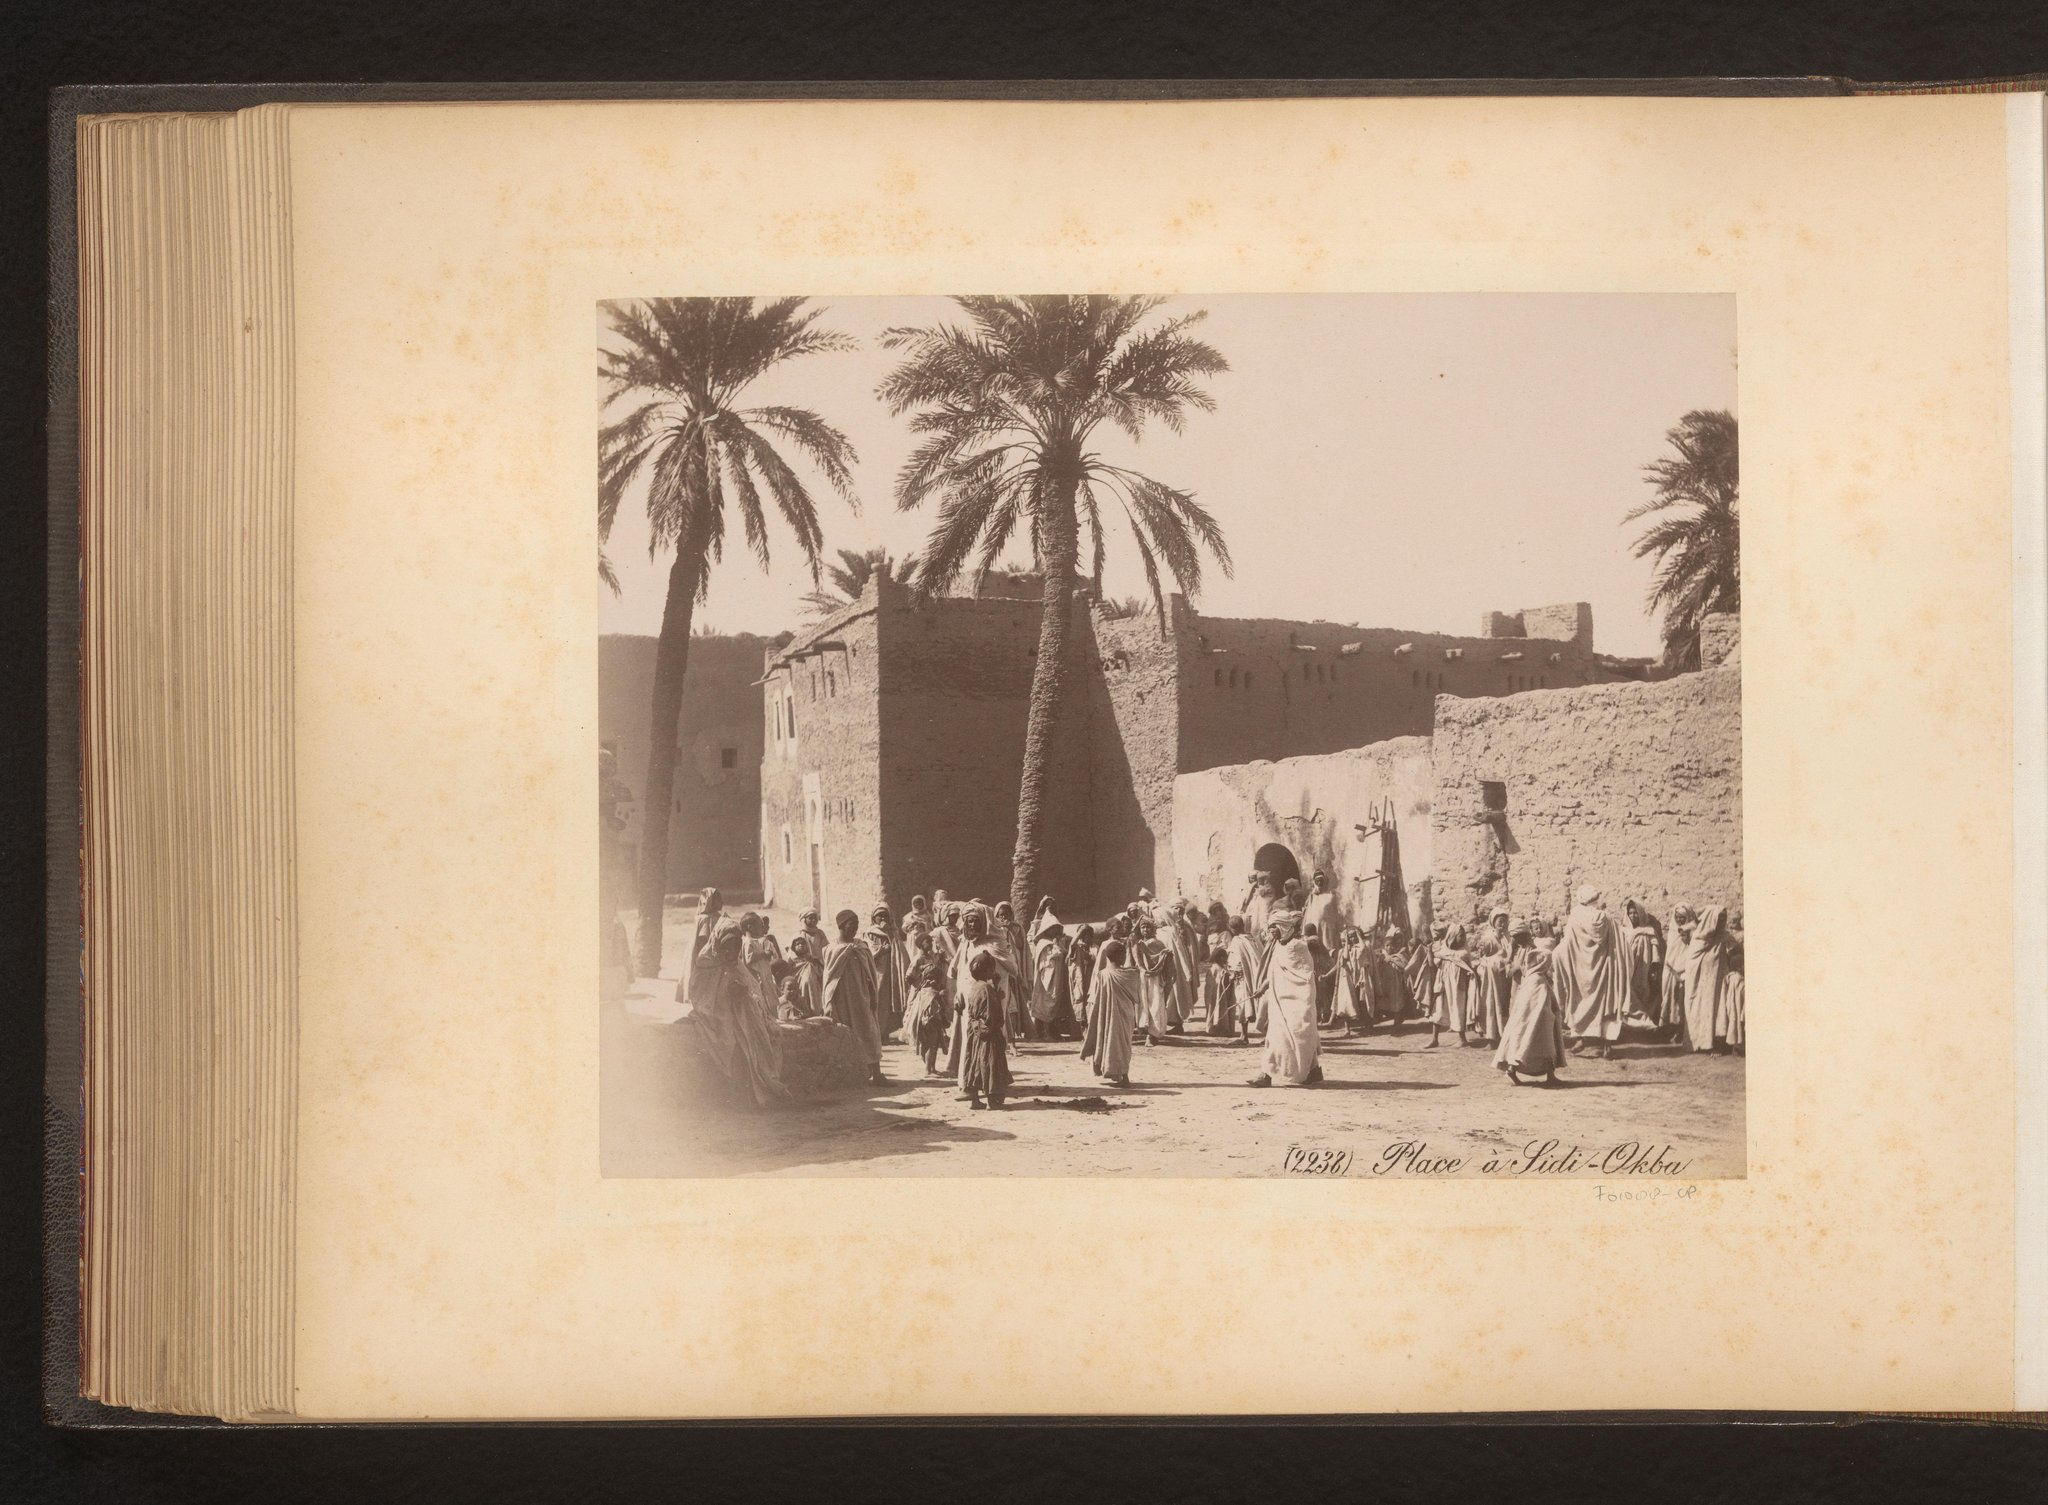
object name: album leaf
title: Place a Sidi-Okba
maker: Anonymous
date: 1880-1900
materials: photographic support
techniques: albumen print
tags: square, place, circus, etc., historical persons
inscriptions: number: ‘1958’